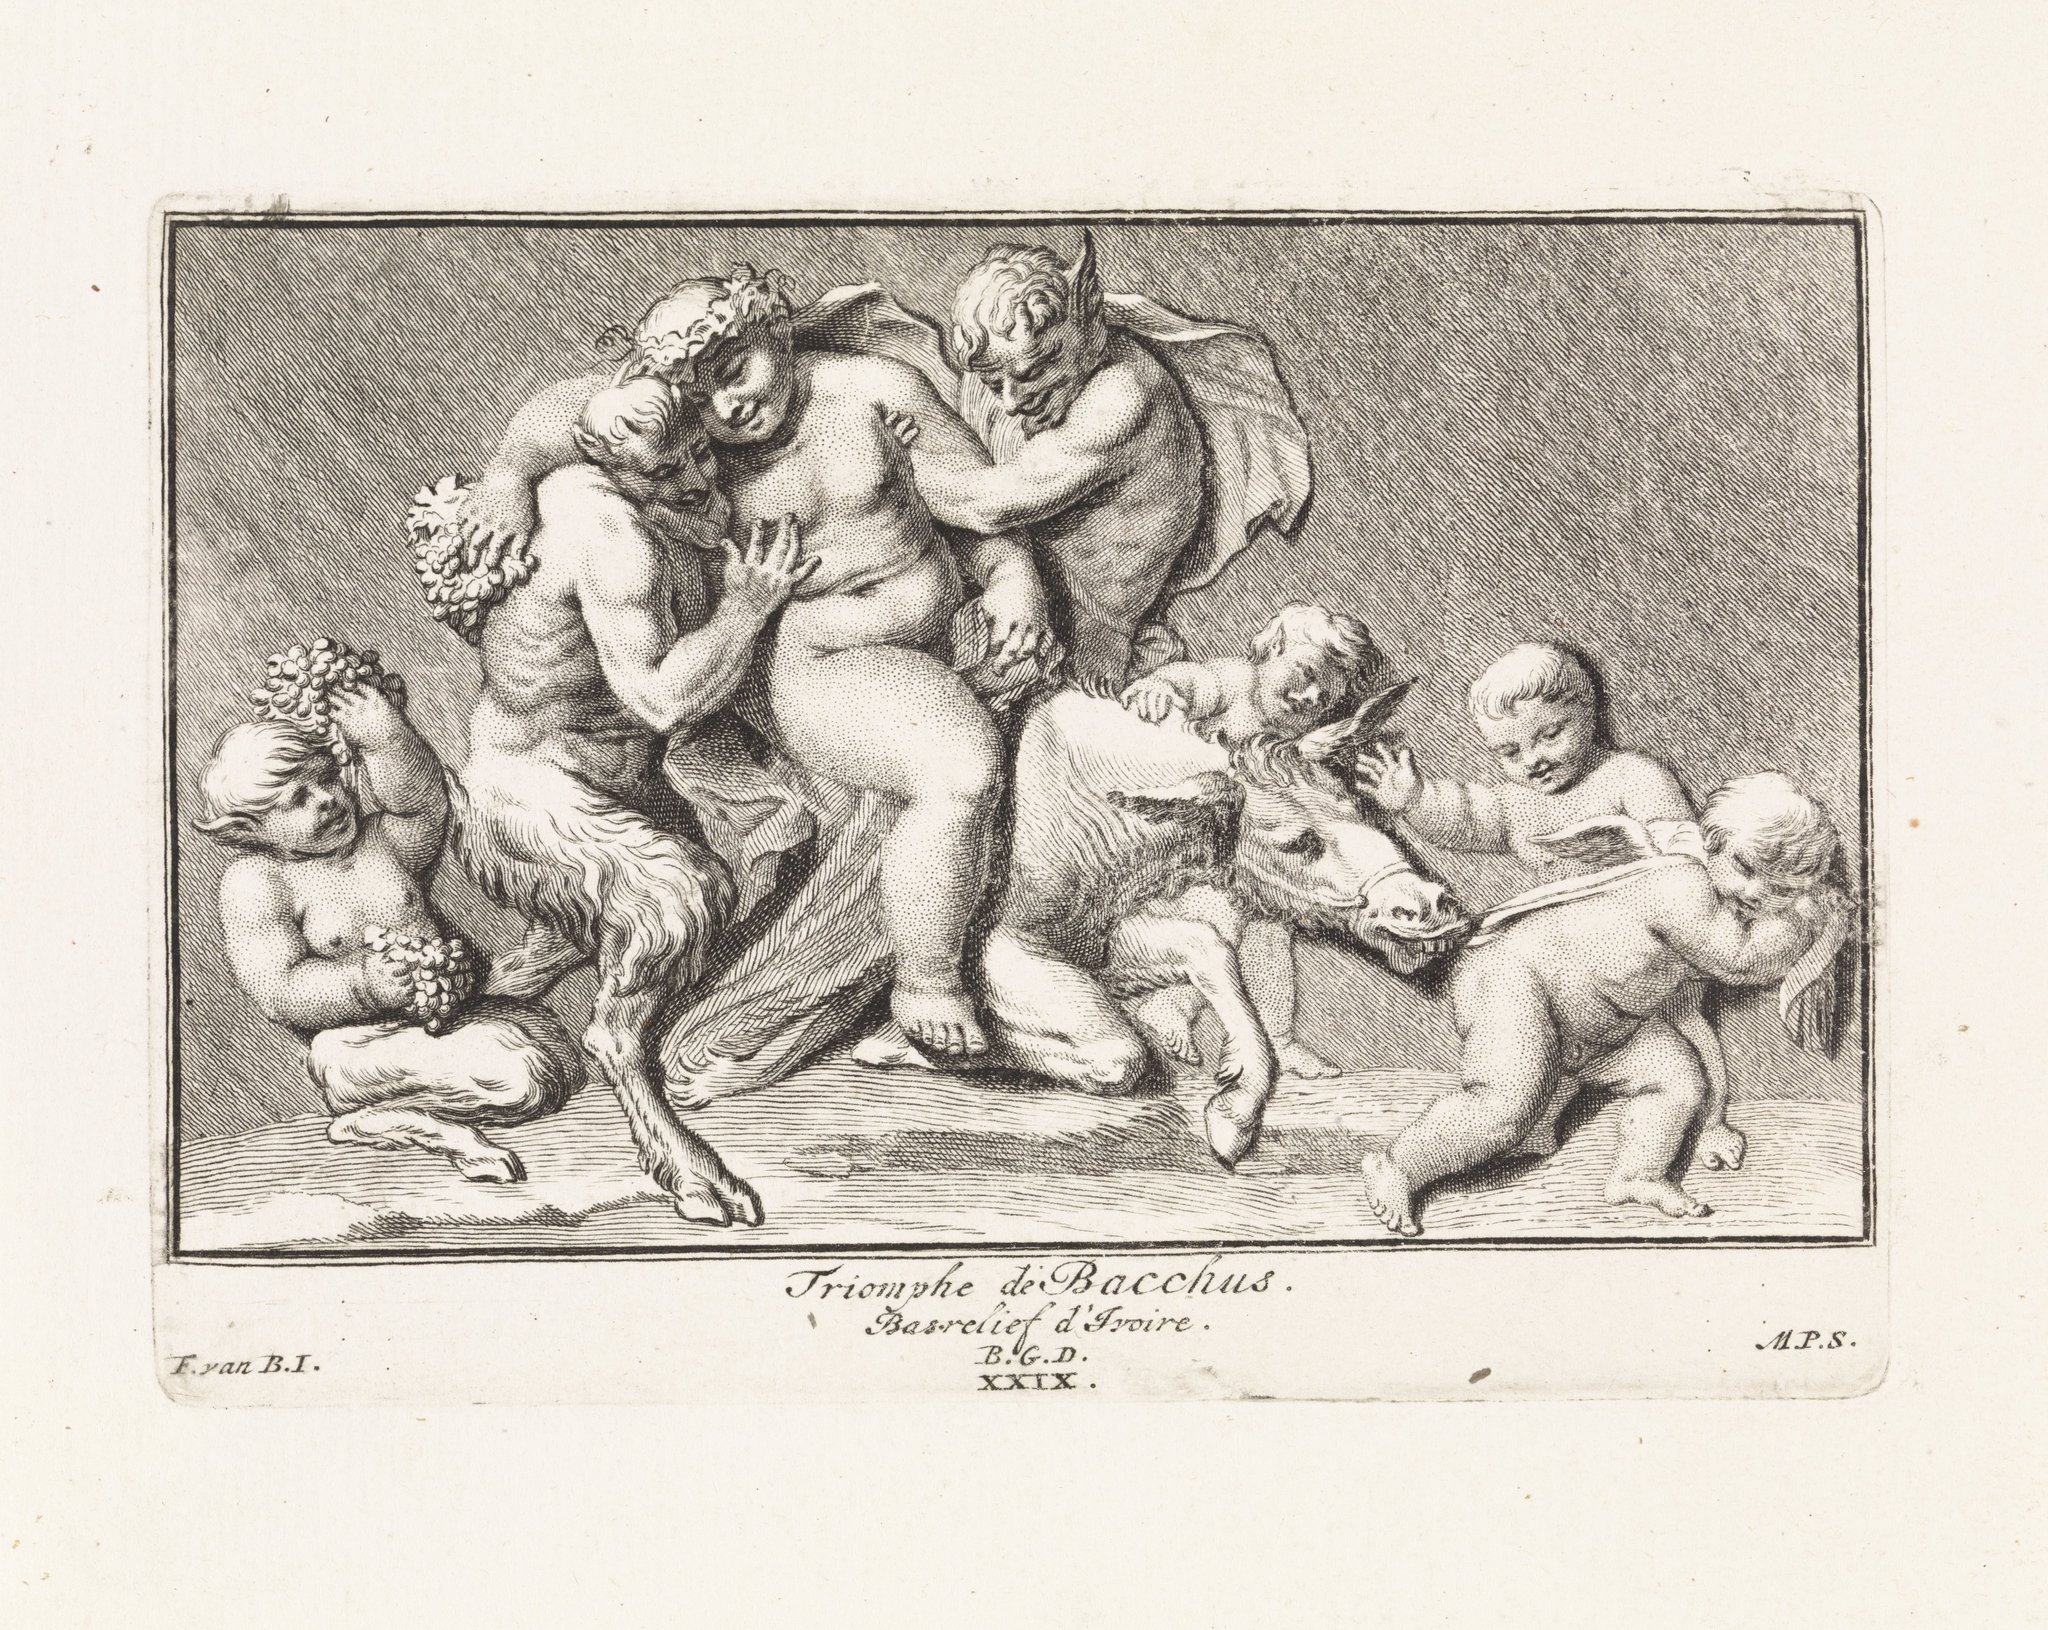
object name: book illustration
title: Bas-reliëf met triomftocht van Bacchus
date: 1727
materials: paper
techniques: engraving, etching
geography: amsterdam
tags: triumph of bacchus; 'carro di bacco' (ripa), piece of sculpture, reproduction of a piece of sculpture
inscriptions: collector's mark: Lugt 2228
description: Prent ook gebruikt in: Bossuit, Francis van. Cabinet de l'art de schulpture (...). Executé en yvoire (...). = Beeld-snyders kunst-kabinet (...). = Statues, or Art's cabinet. Amsterdam: M. Pool, 1727.